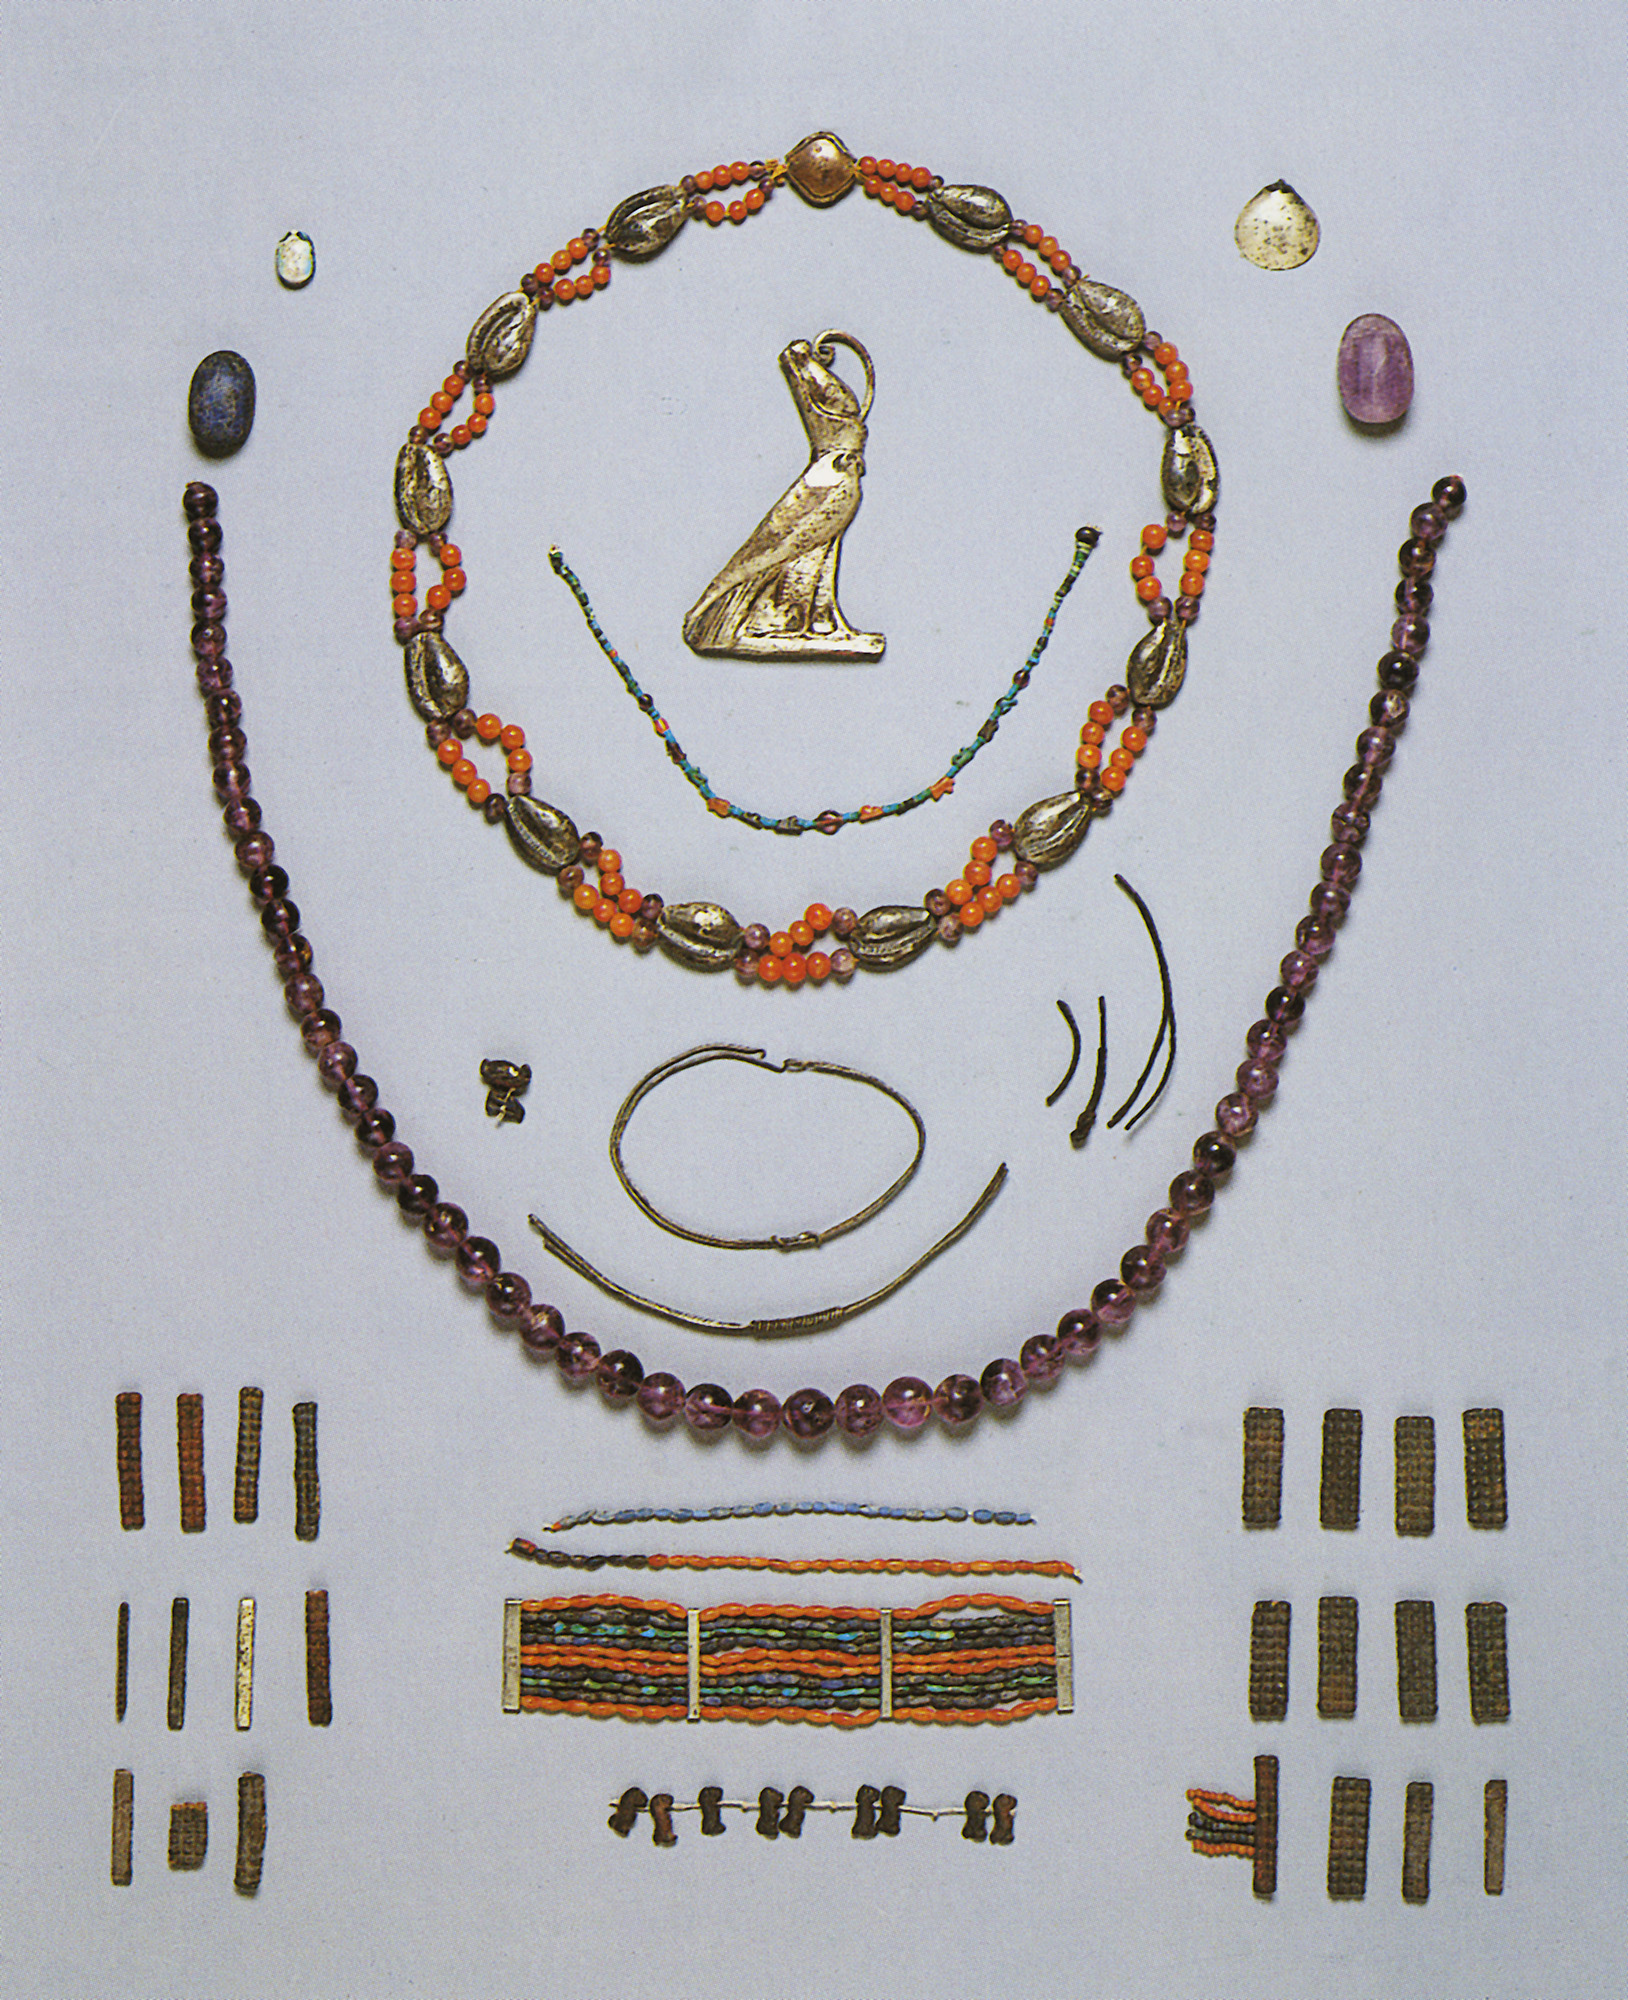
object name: object from theban tomb mma 840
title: Objects from Theban Tomb MMA 840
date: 1850-1700 BCE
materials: gemstone, lapis lazuli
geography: egypt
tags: scarabs,boats